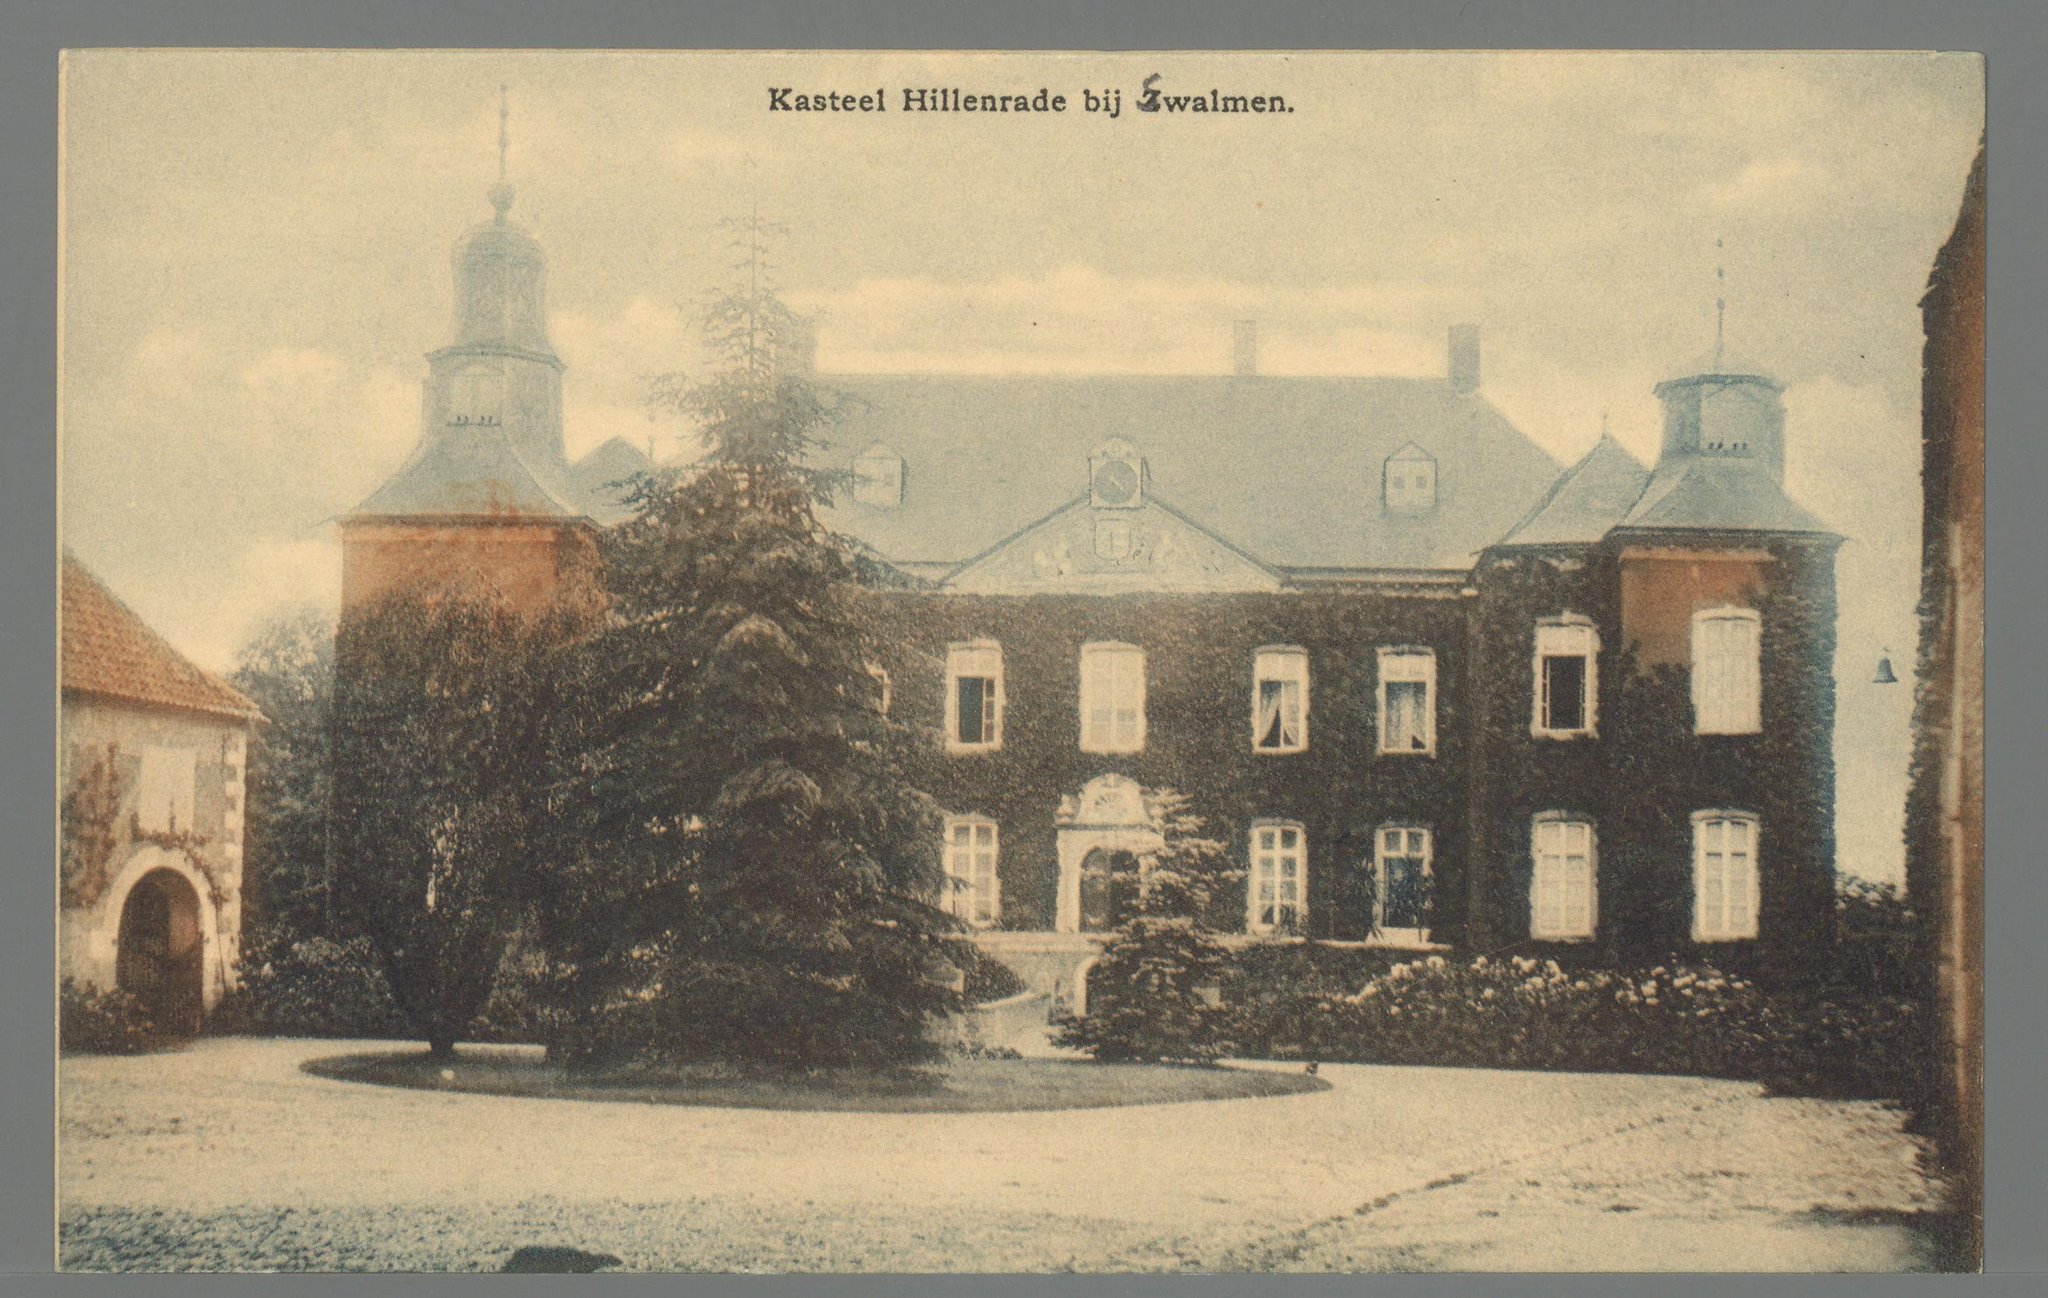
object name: ansichtkaart, prentbriefkaart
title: Kasteel Hillenrade bij Zwalmen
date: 1905-1930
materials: cardboard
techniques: collotype process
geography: swalmen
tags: castle